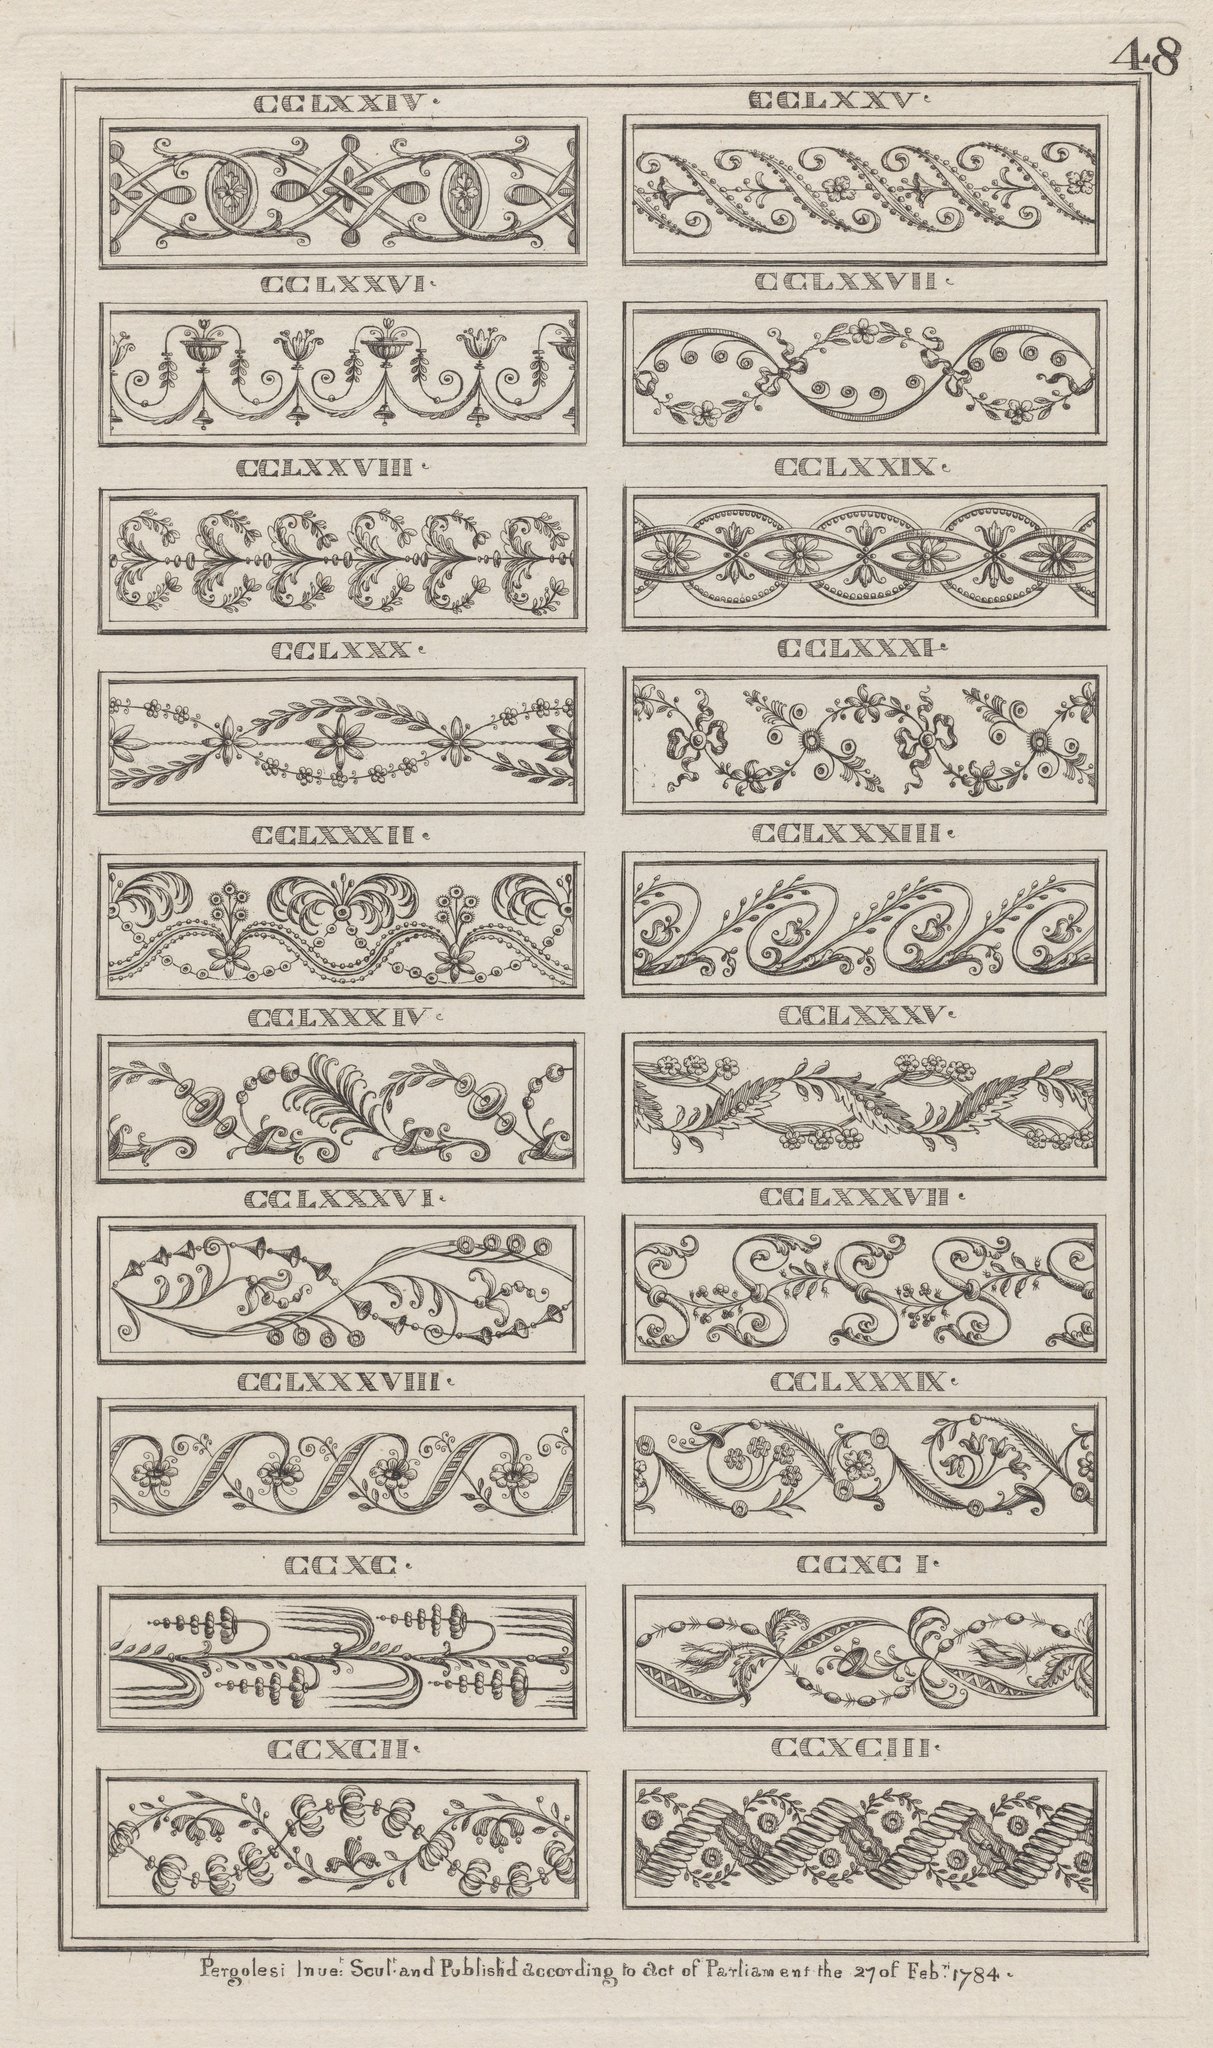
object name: print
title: Panels of Ornament, nos. CCLXXIV–CCXCIII, plate 48 from "Designs for Various Ornaments"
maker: michelangelo pergolesi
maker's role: artist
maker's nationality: italian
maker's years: 1760-1801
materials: ink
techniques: etching, printing